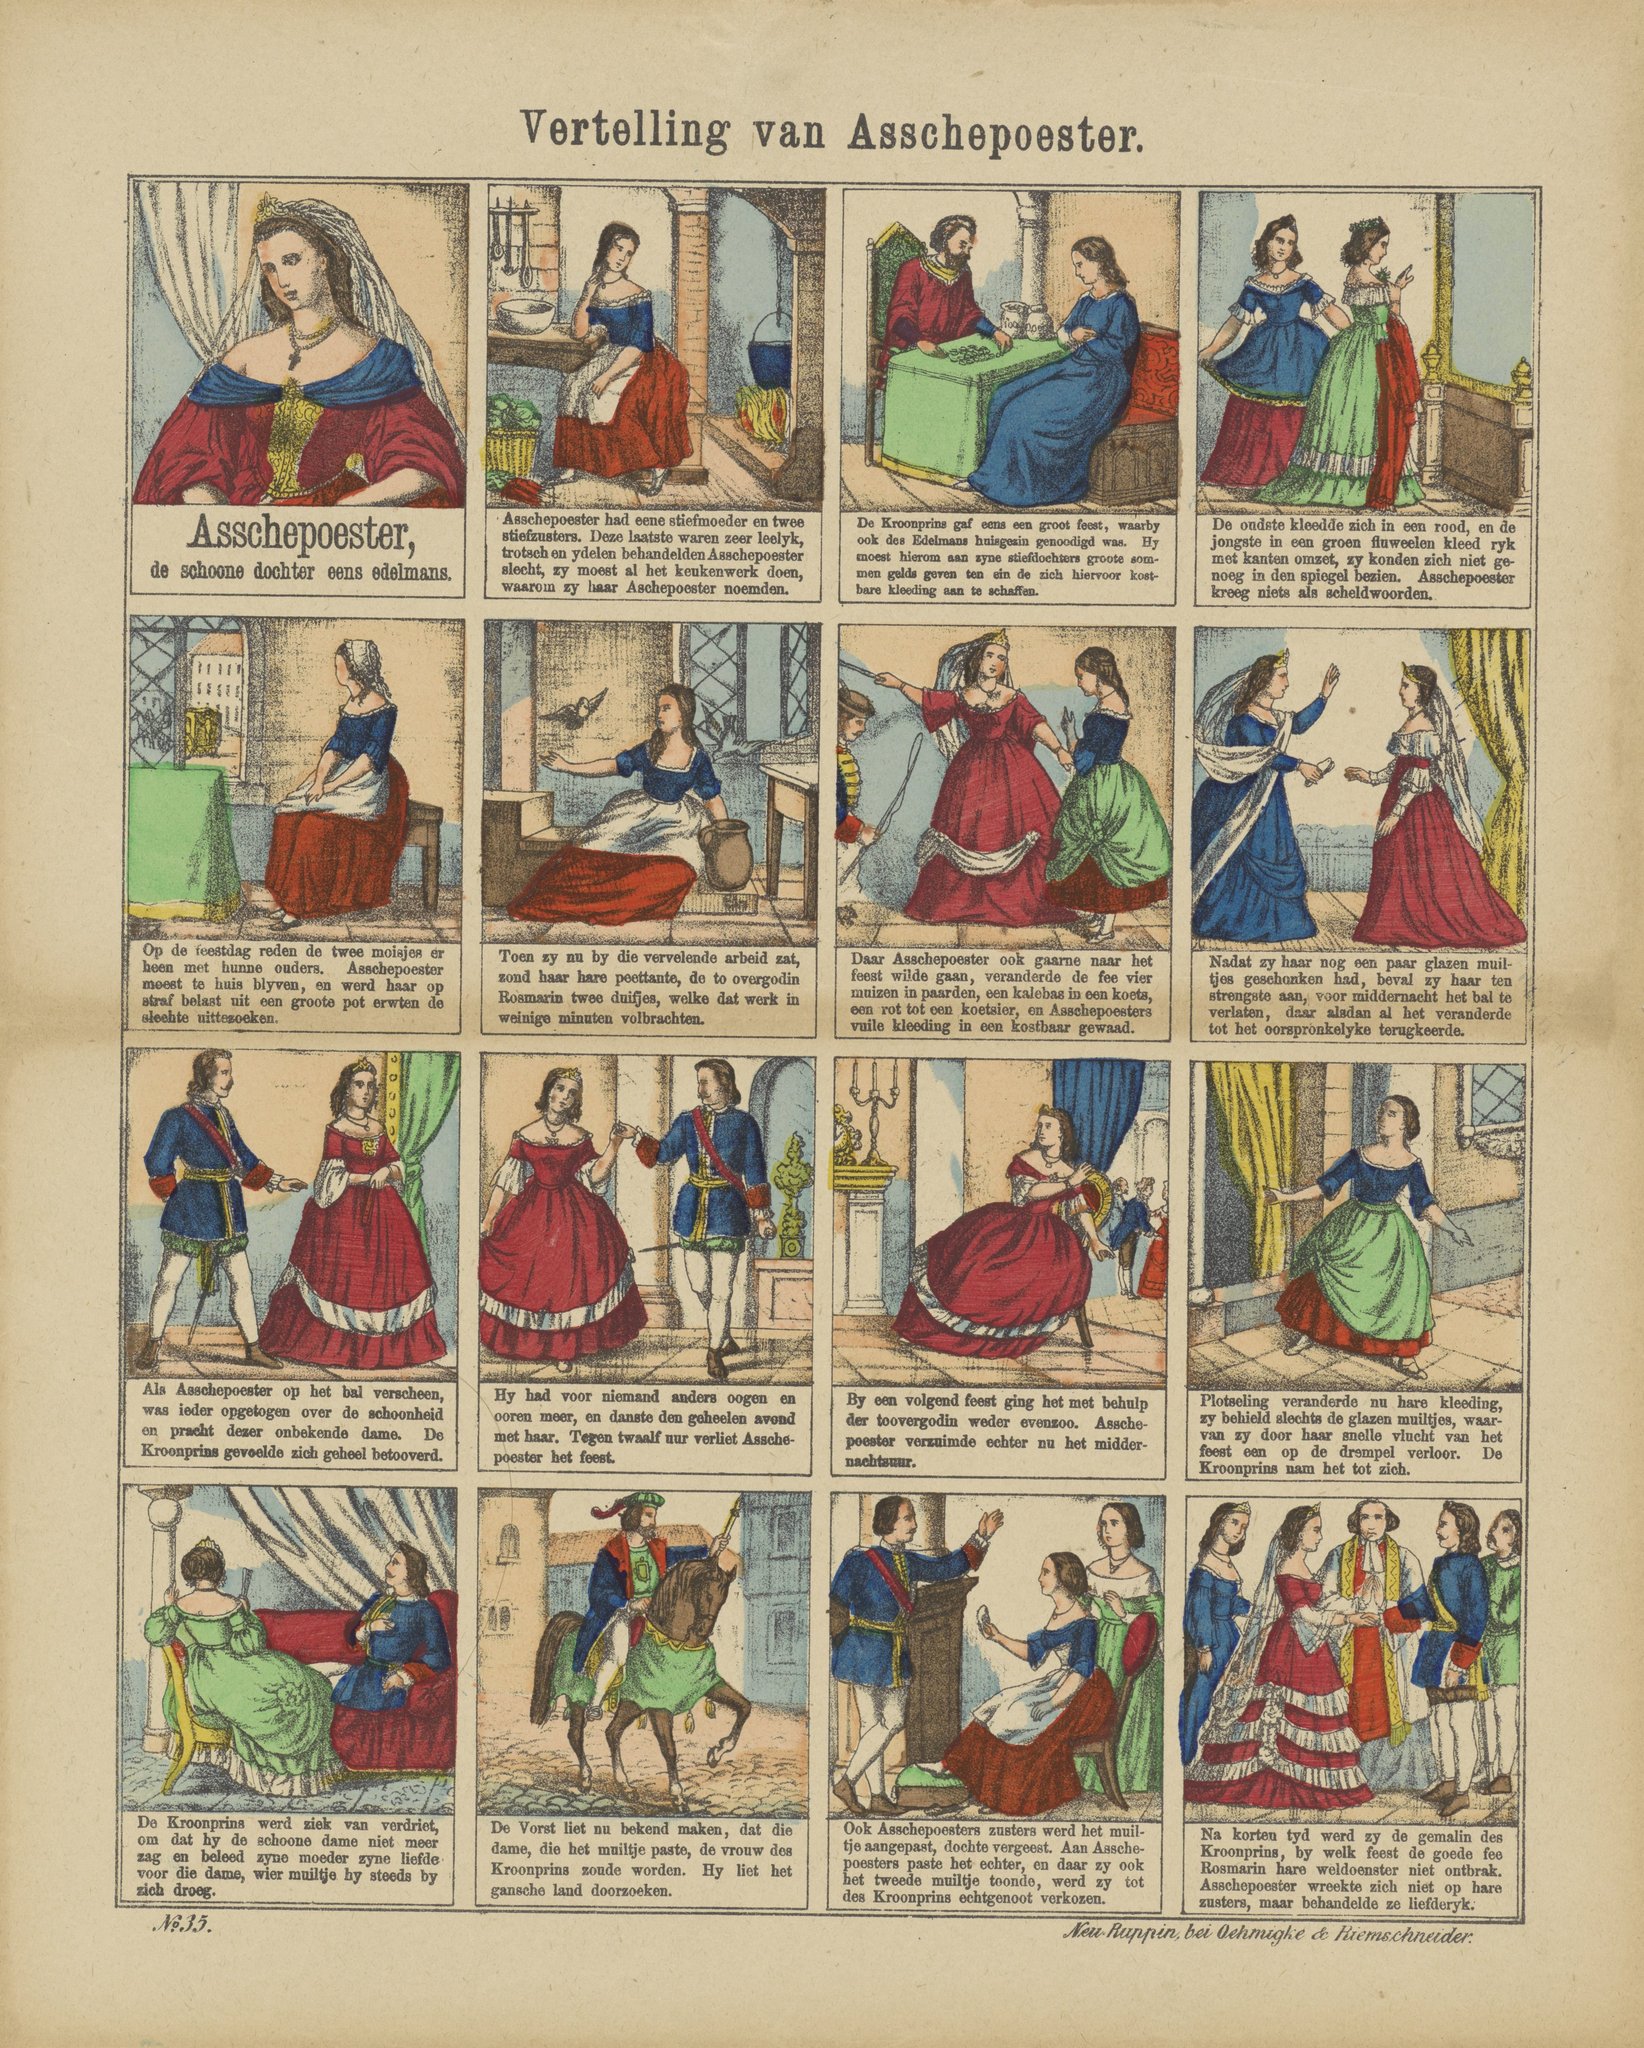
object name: popular print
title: Vertelling van Asschepoester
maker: Anonymous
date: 1828-1937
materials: paper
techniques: hand coloring, letterpress printing, lithograph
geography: neuruppin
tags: tales and fairy tales (with title)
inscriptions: collector's mark: Lugt 2760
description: Blad met 16 voorstellingen uit het sprookje van Assepoester. Onder elke afbeelding een onderschrift. Genummerd linksonder: No. 35.